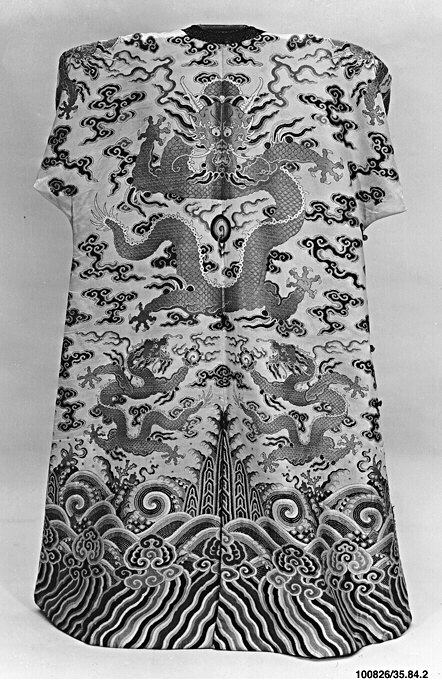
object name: robe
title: Theatrical Robe for a Military Role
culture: chinese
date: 1701-1800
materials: metal thread, silk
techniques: brocade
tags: dragons